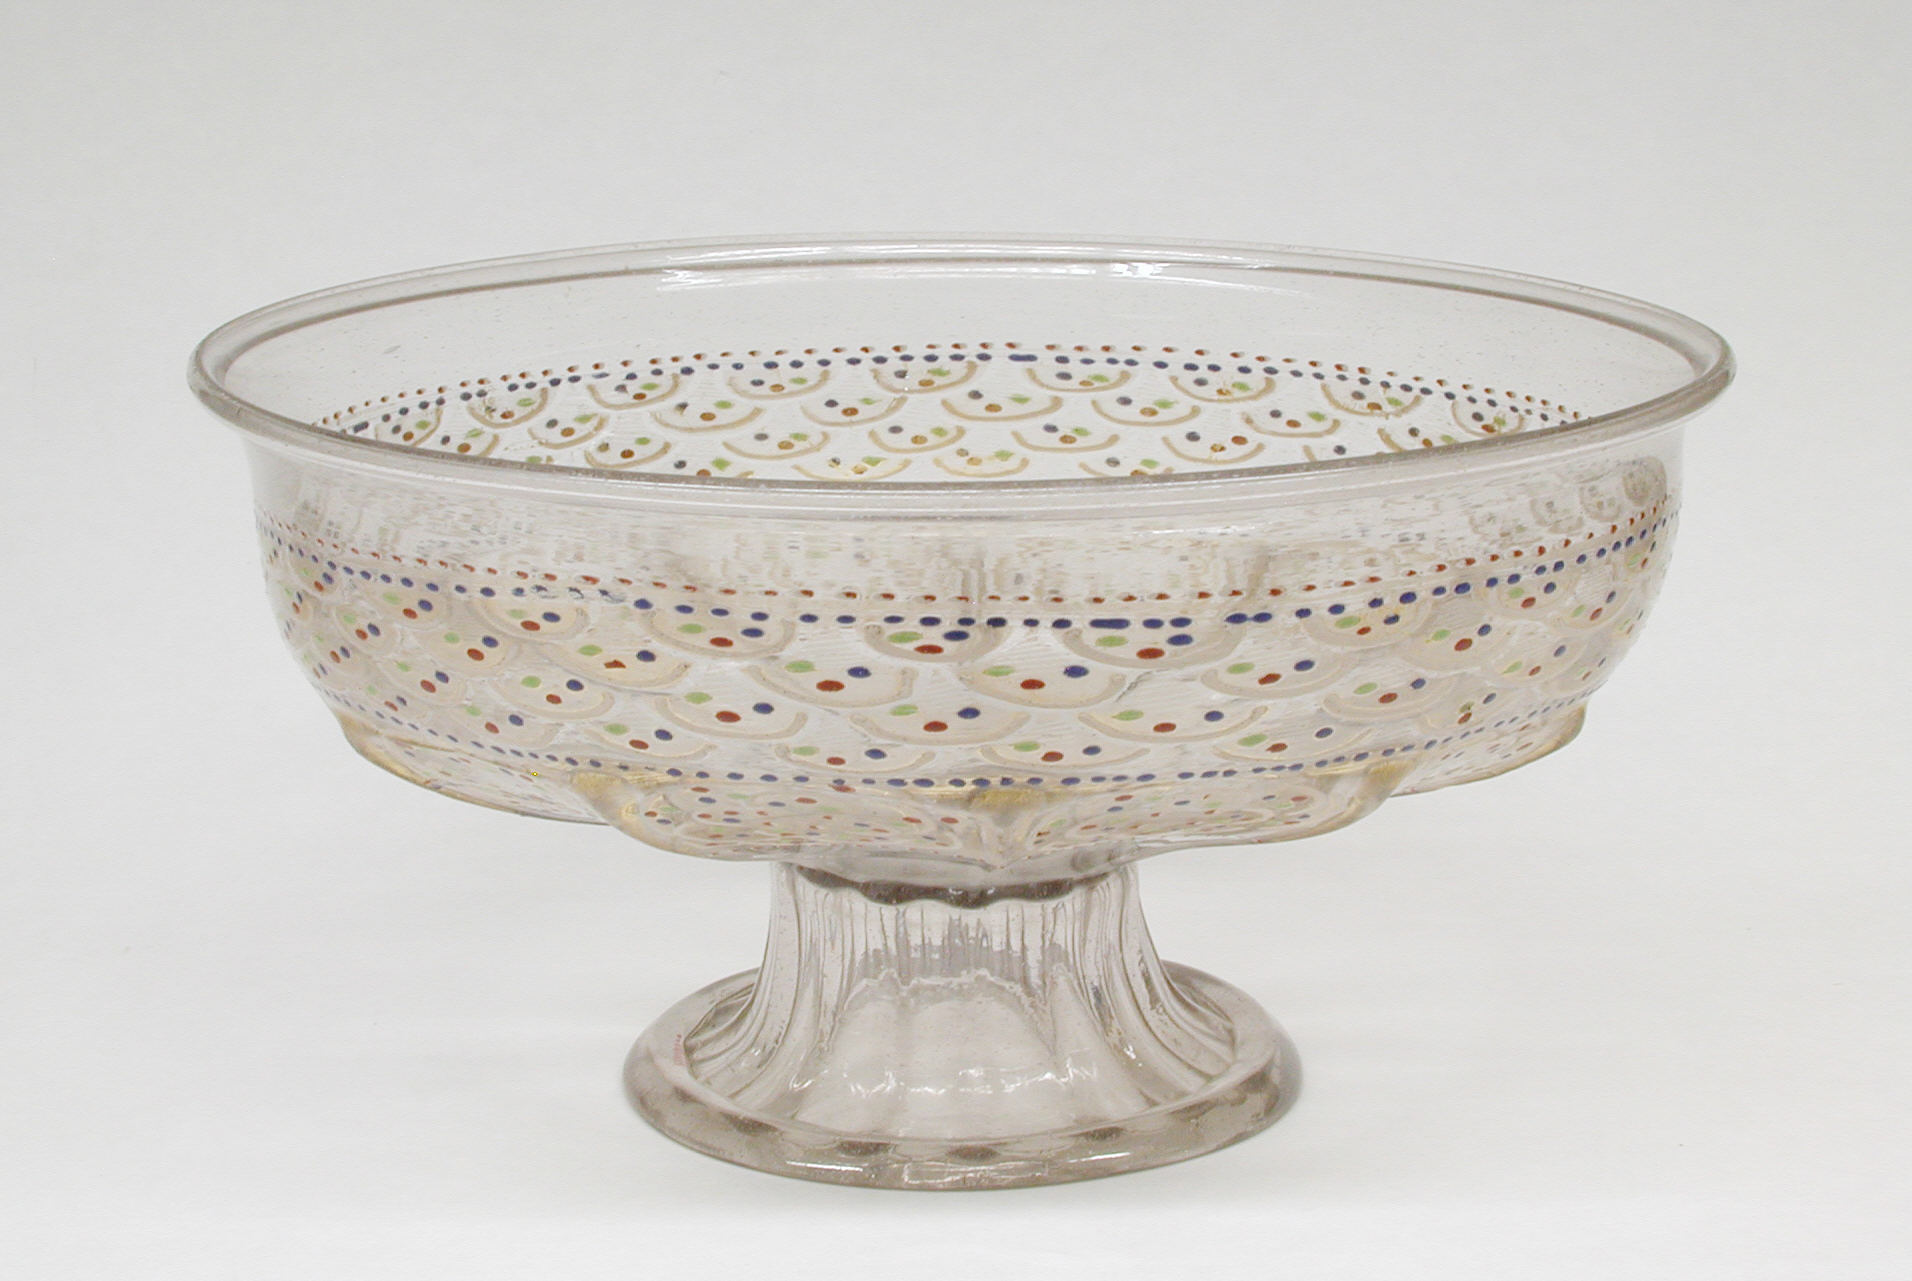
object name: bowl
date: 1501-1533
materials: gilt, glass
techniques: enamel